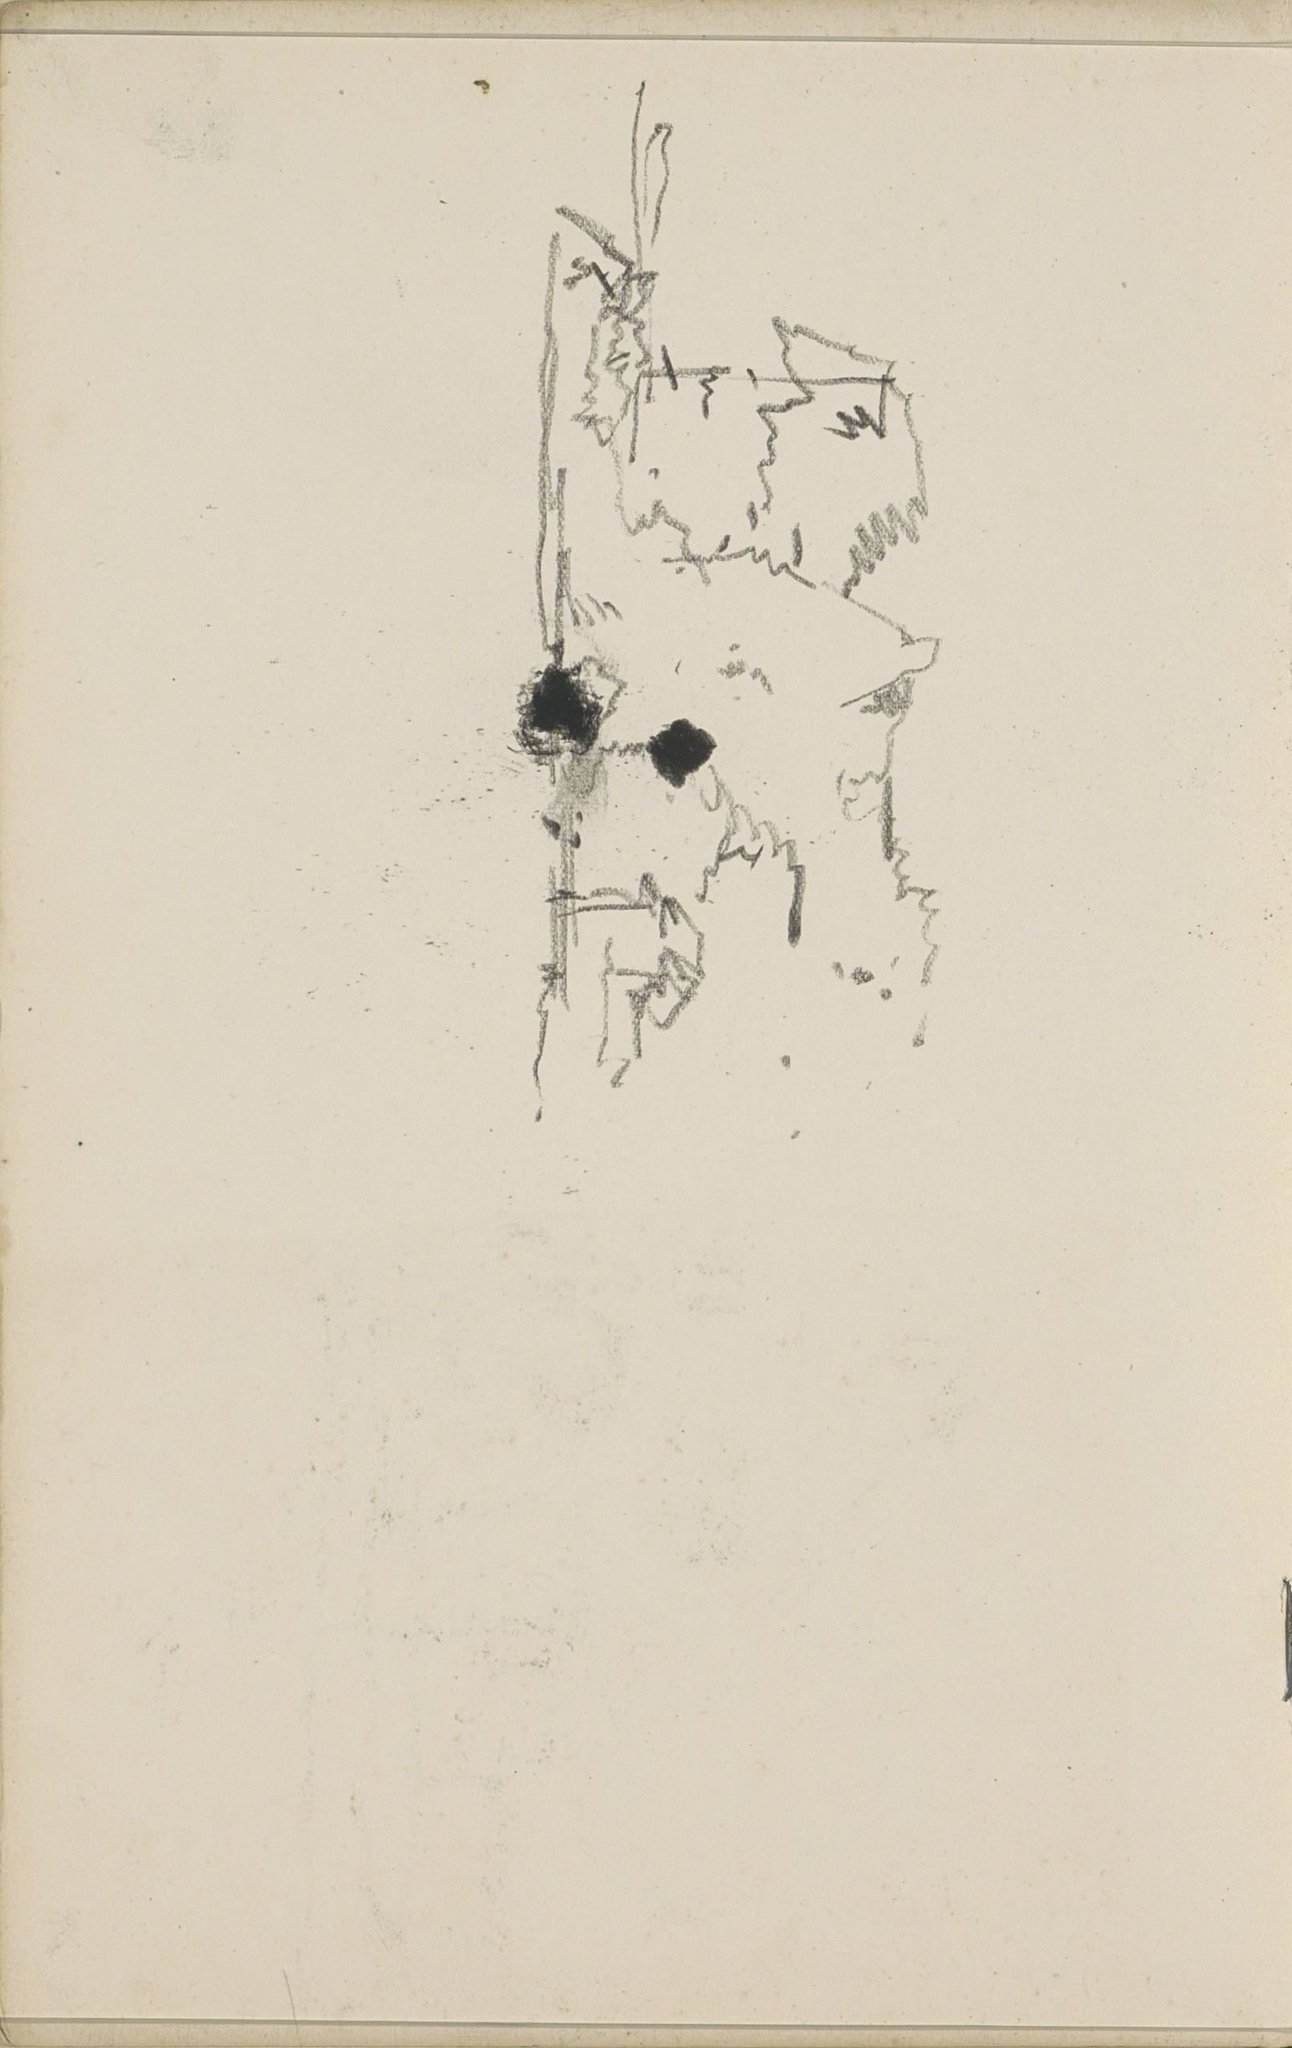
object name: sketchbook leaf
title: Rij huizen aan een waterkant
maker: cornelis vreedenburgh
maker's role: draughtsman, print maker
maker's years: 1880-1946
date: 1890-1946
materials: chalk, paper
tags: housing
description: Blad 43 verso uit een schetsboek met 45 bladen.